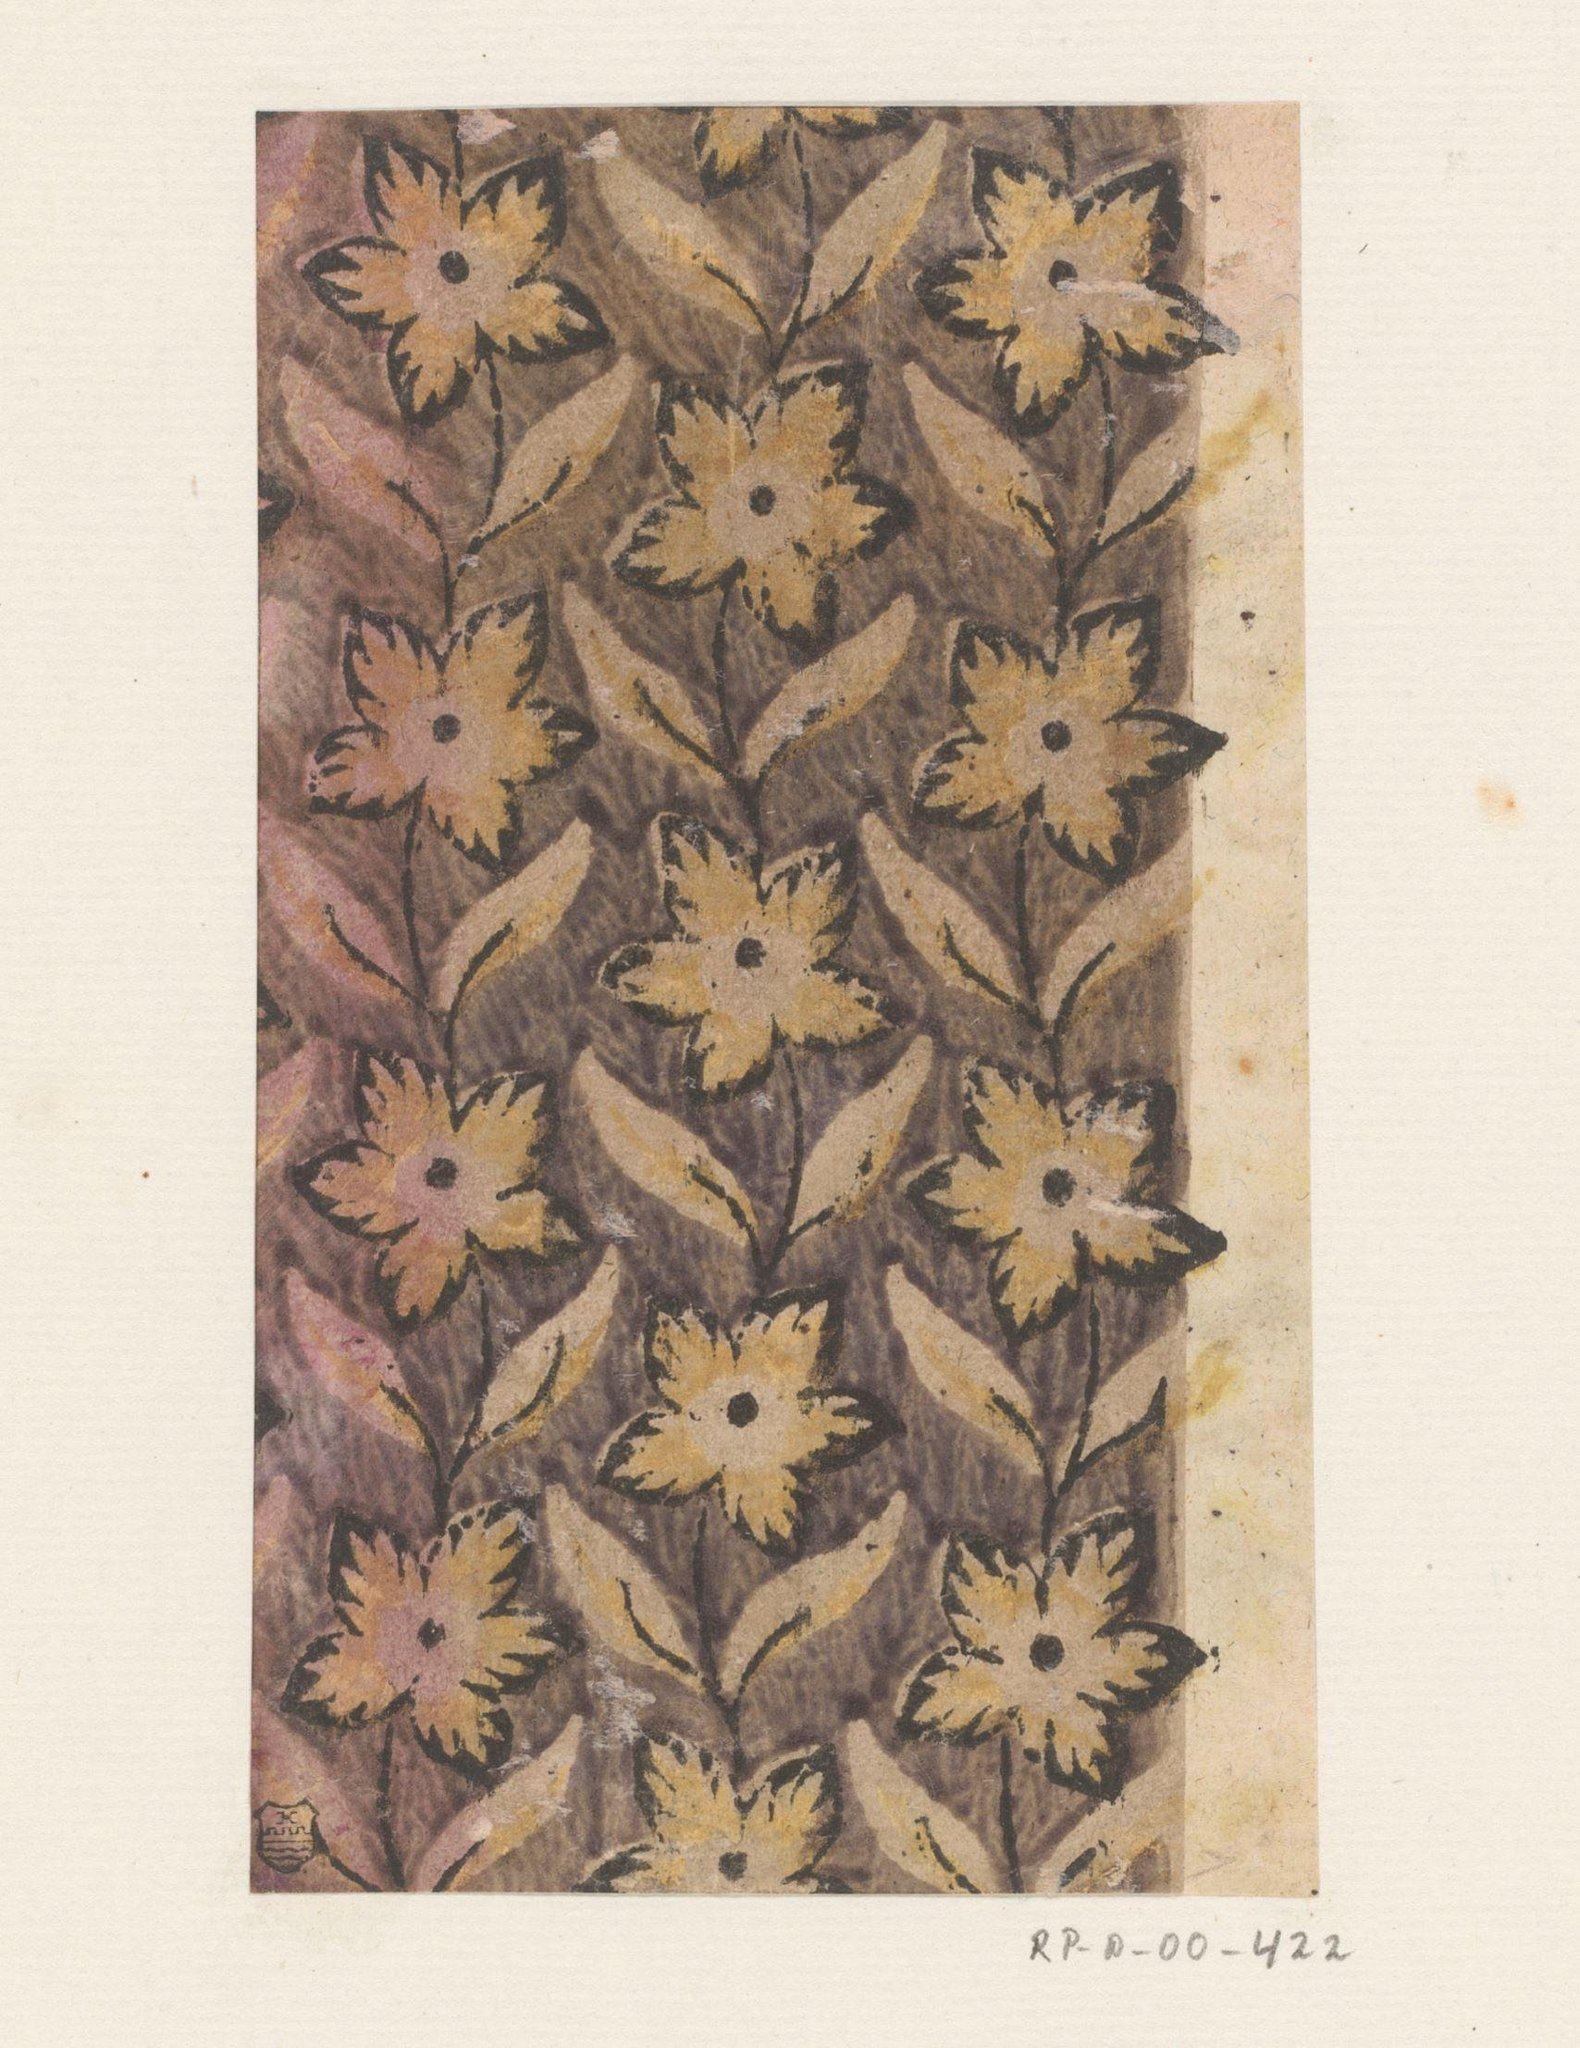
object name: printed paper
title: Blad met banenpatroon van uitgespaarde bloemen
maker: Anonymous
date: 1700-1850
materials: paper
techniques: printing block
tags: ornament derived from plant forms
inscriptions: collector's mark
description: Blad met banenpatroon van aan elkaar verbonden uitgespaarde bloemen.